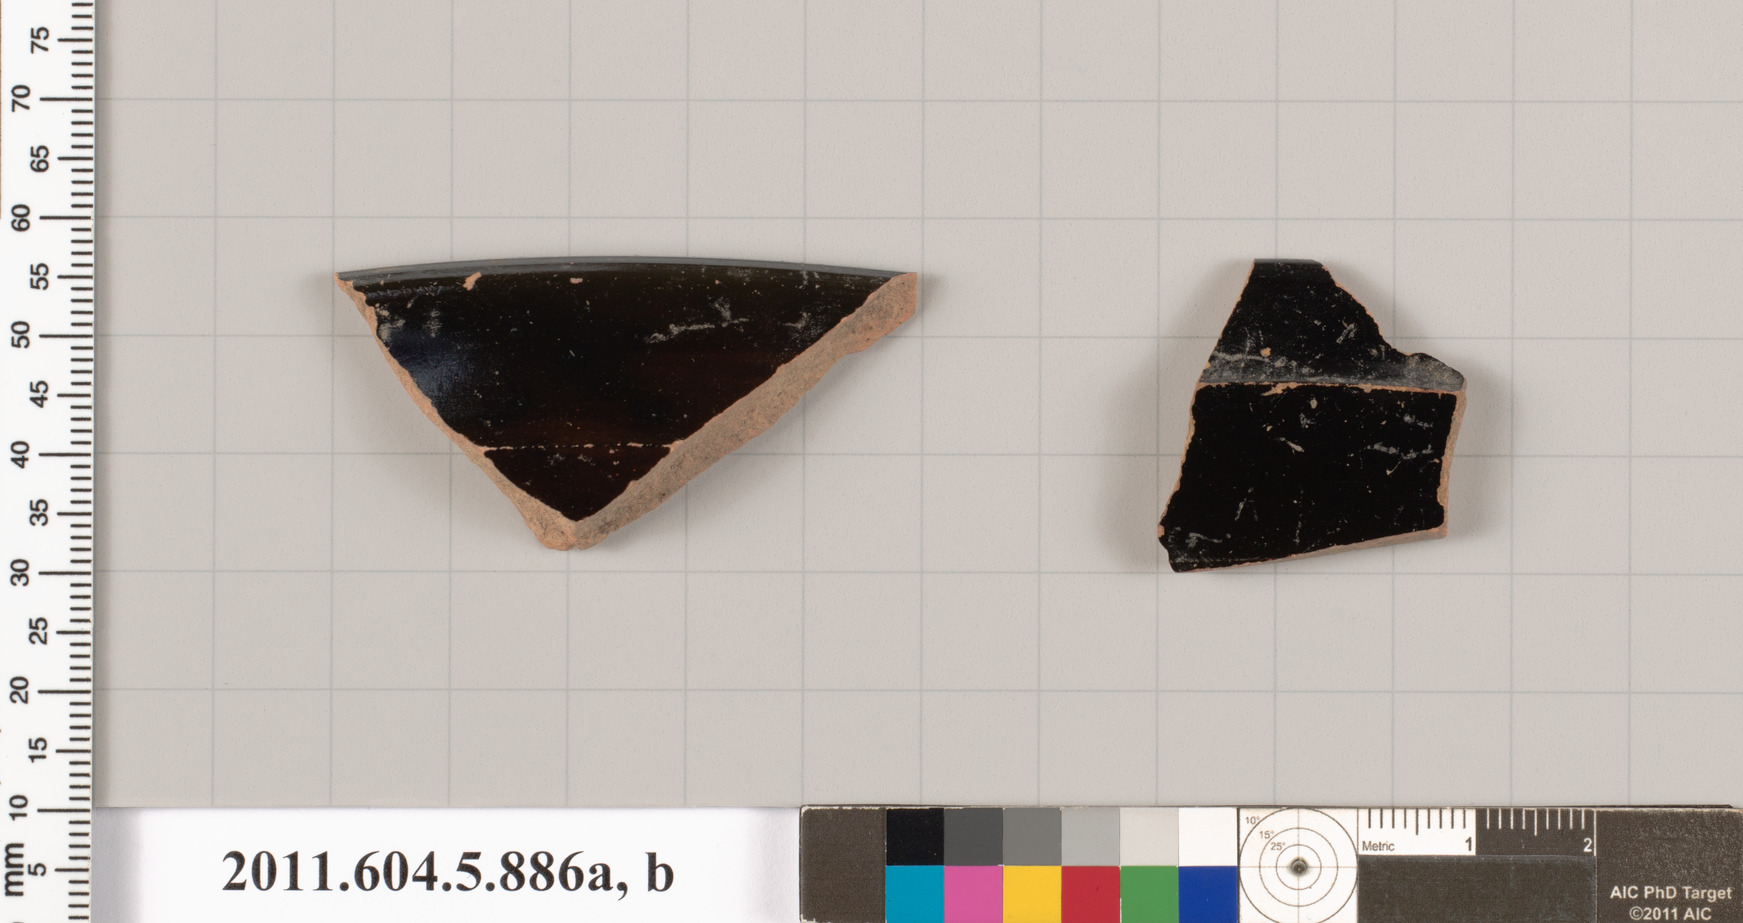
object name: kylix fragment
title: Terracotta fragments of kylikes (drinking cups)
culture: greek, attic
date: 600-401 BCE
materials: terracotta